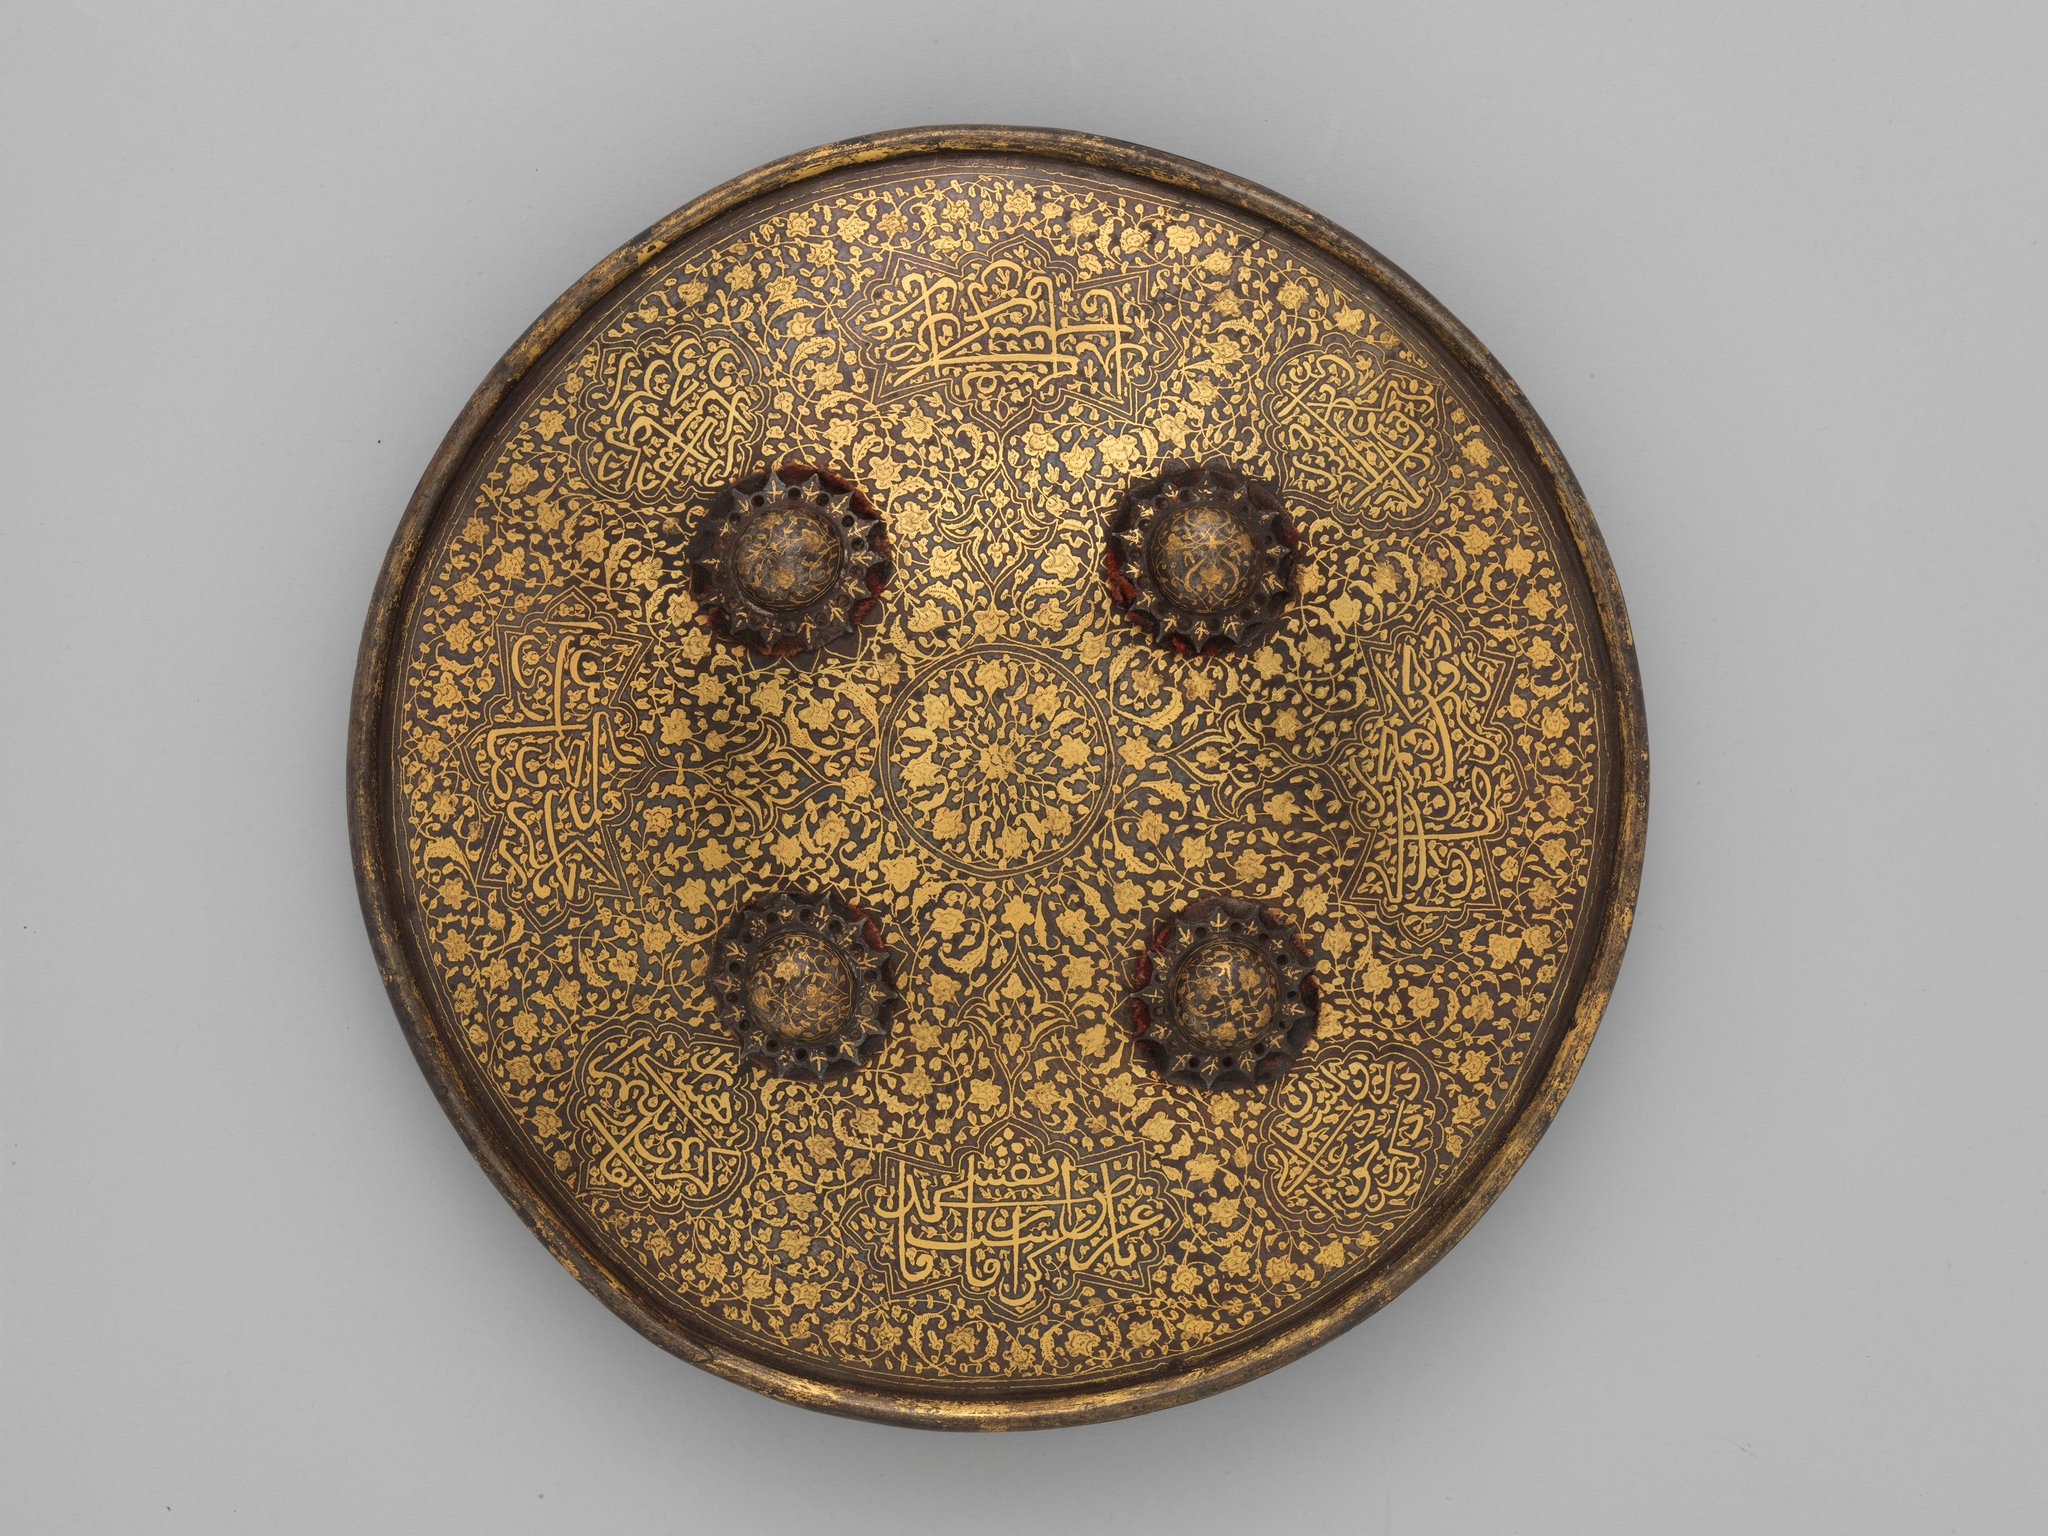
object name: shield i sipar i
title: Shield (Sipar)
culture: persian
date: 1767-1900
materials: gold, iron, steel, velvet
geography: iran